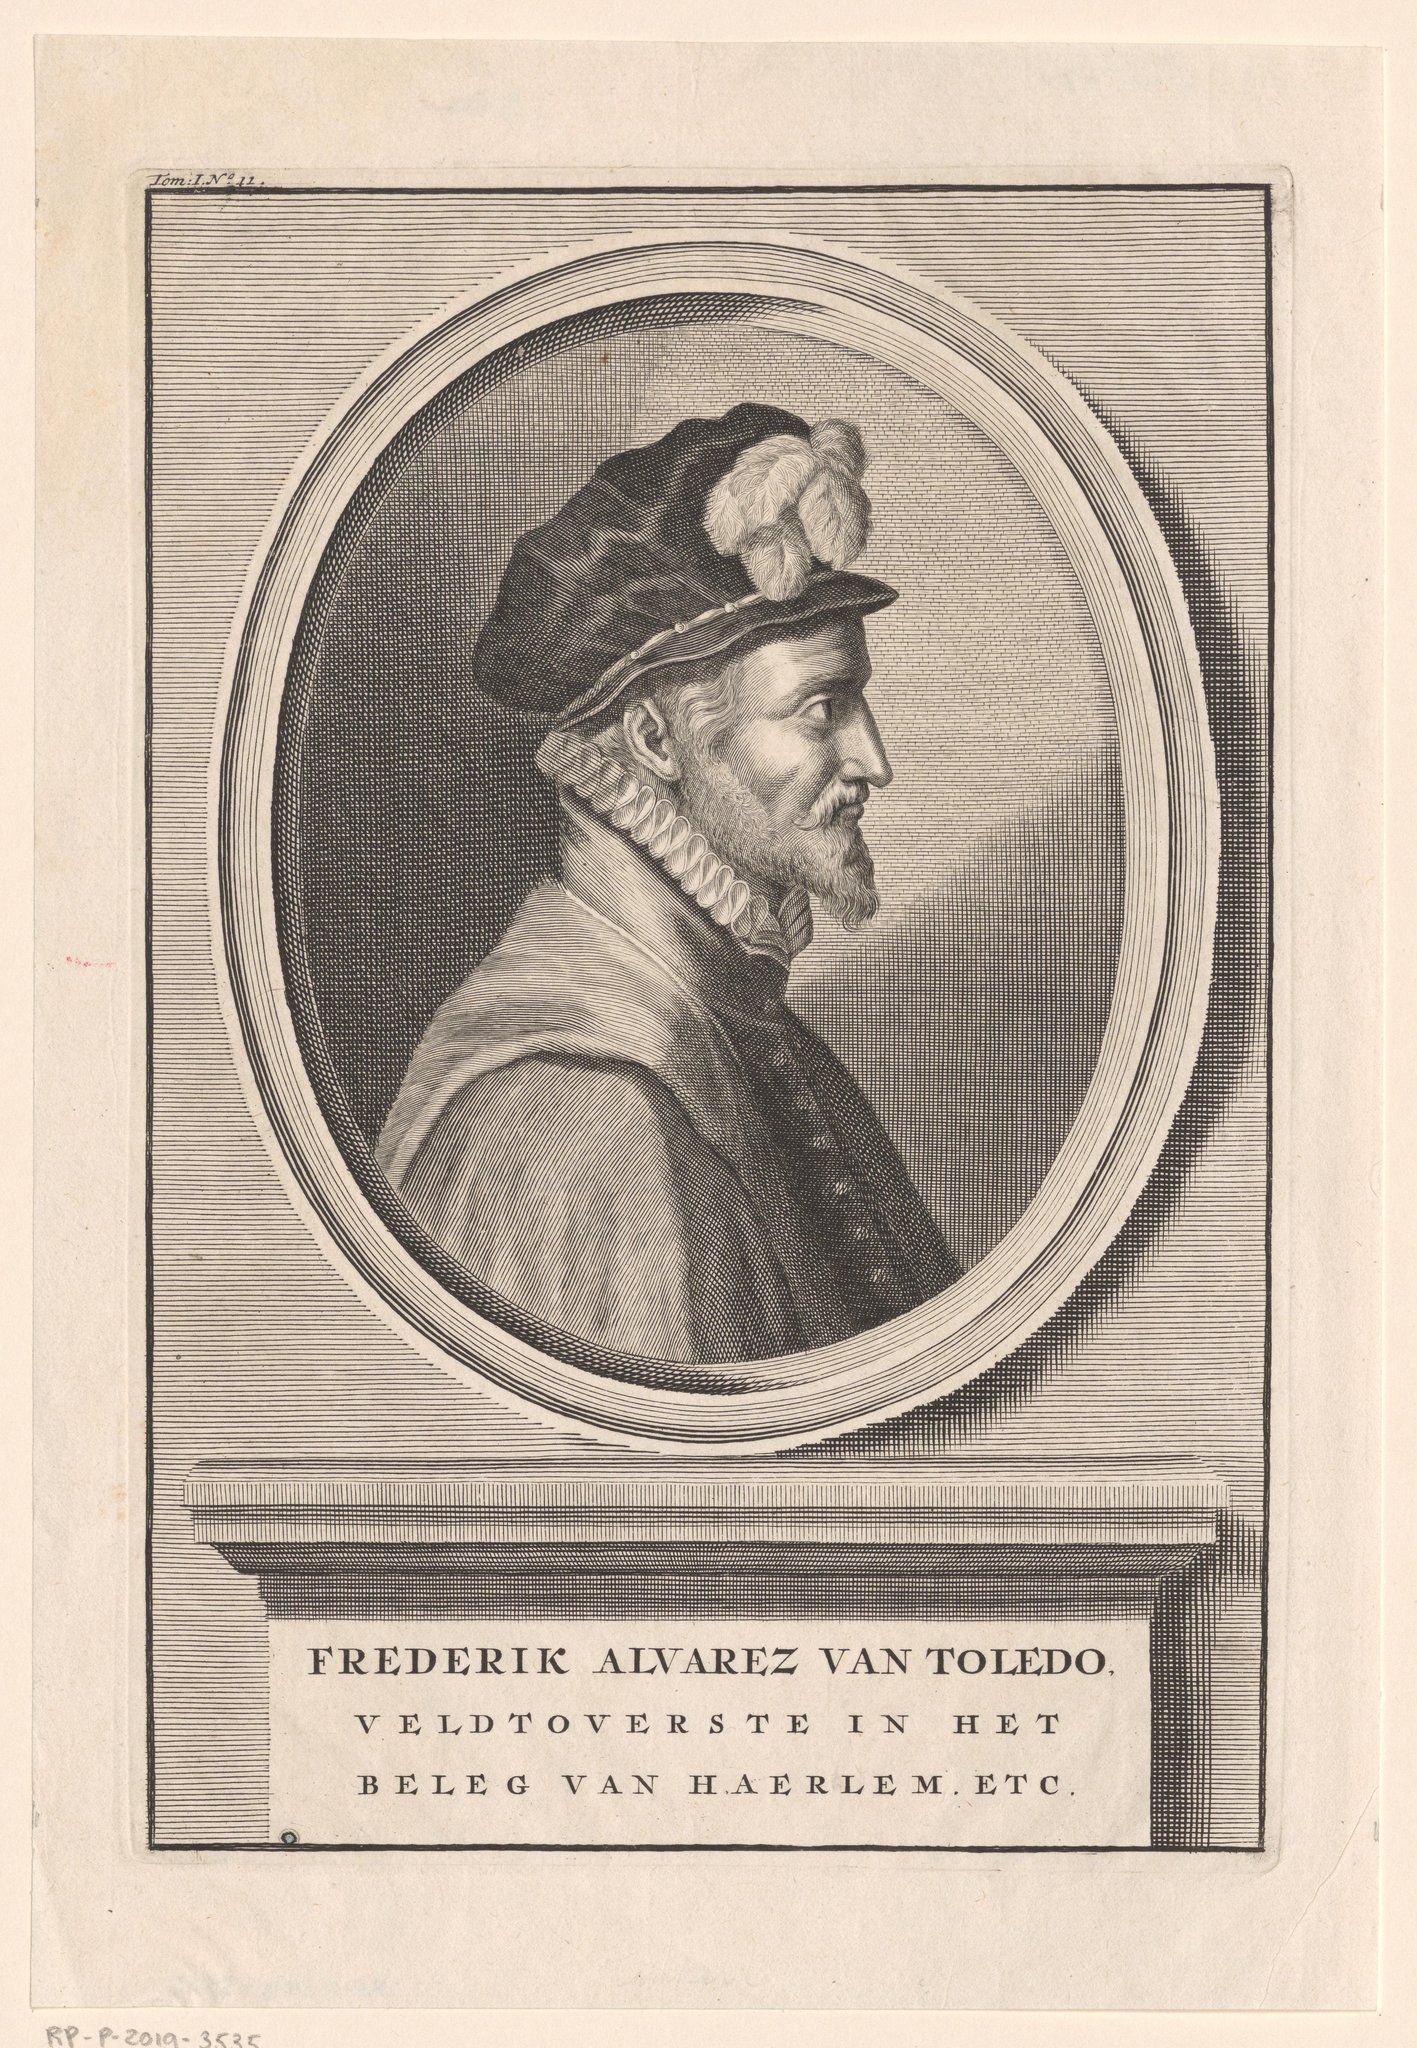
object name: print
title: Portret van Fadrique Álvarez de Toledo, hertog van Alva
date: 1730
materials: paper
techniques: engraving, etching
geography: amsterdam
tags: historical persons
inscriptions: collector's mark: Lugt 2228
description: Prent uit: Clerc, Jean le. Geschiedenissen der Vereenigde Nederlanden, sedert den aanvang van die republyk tot op den vrede van Utrecht (...). Amsterdam: Zacharias Chatelain, 1730, dl. 1.